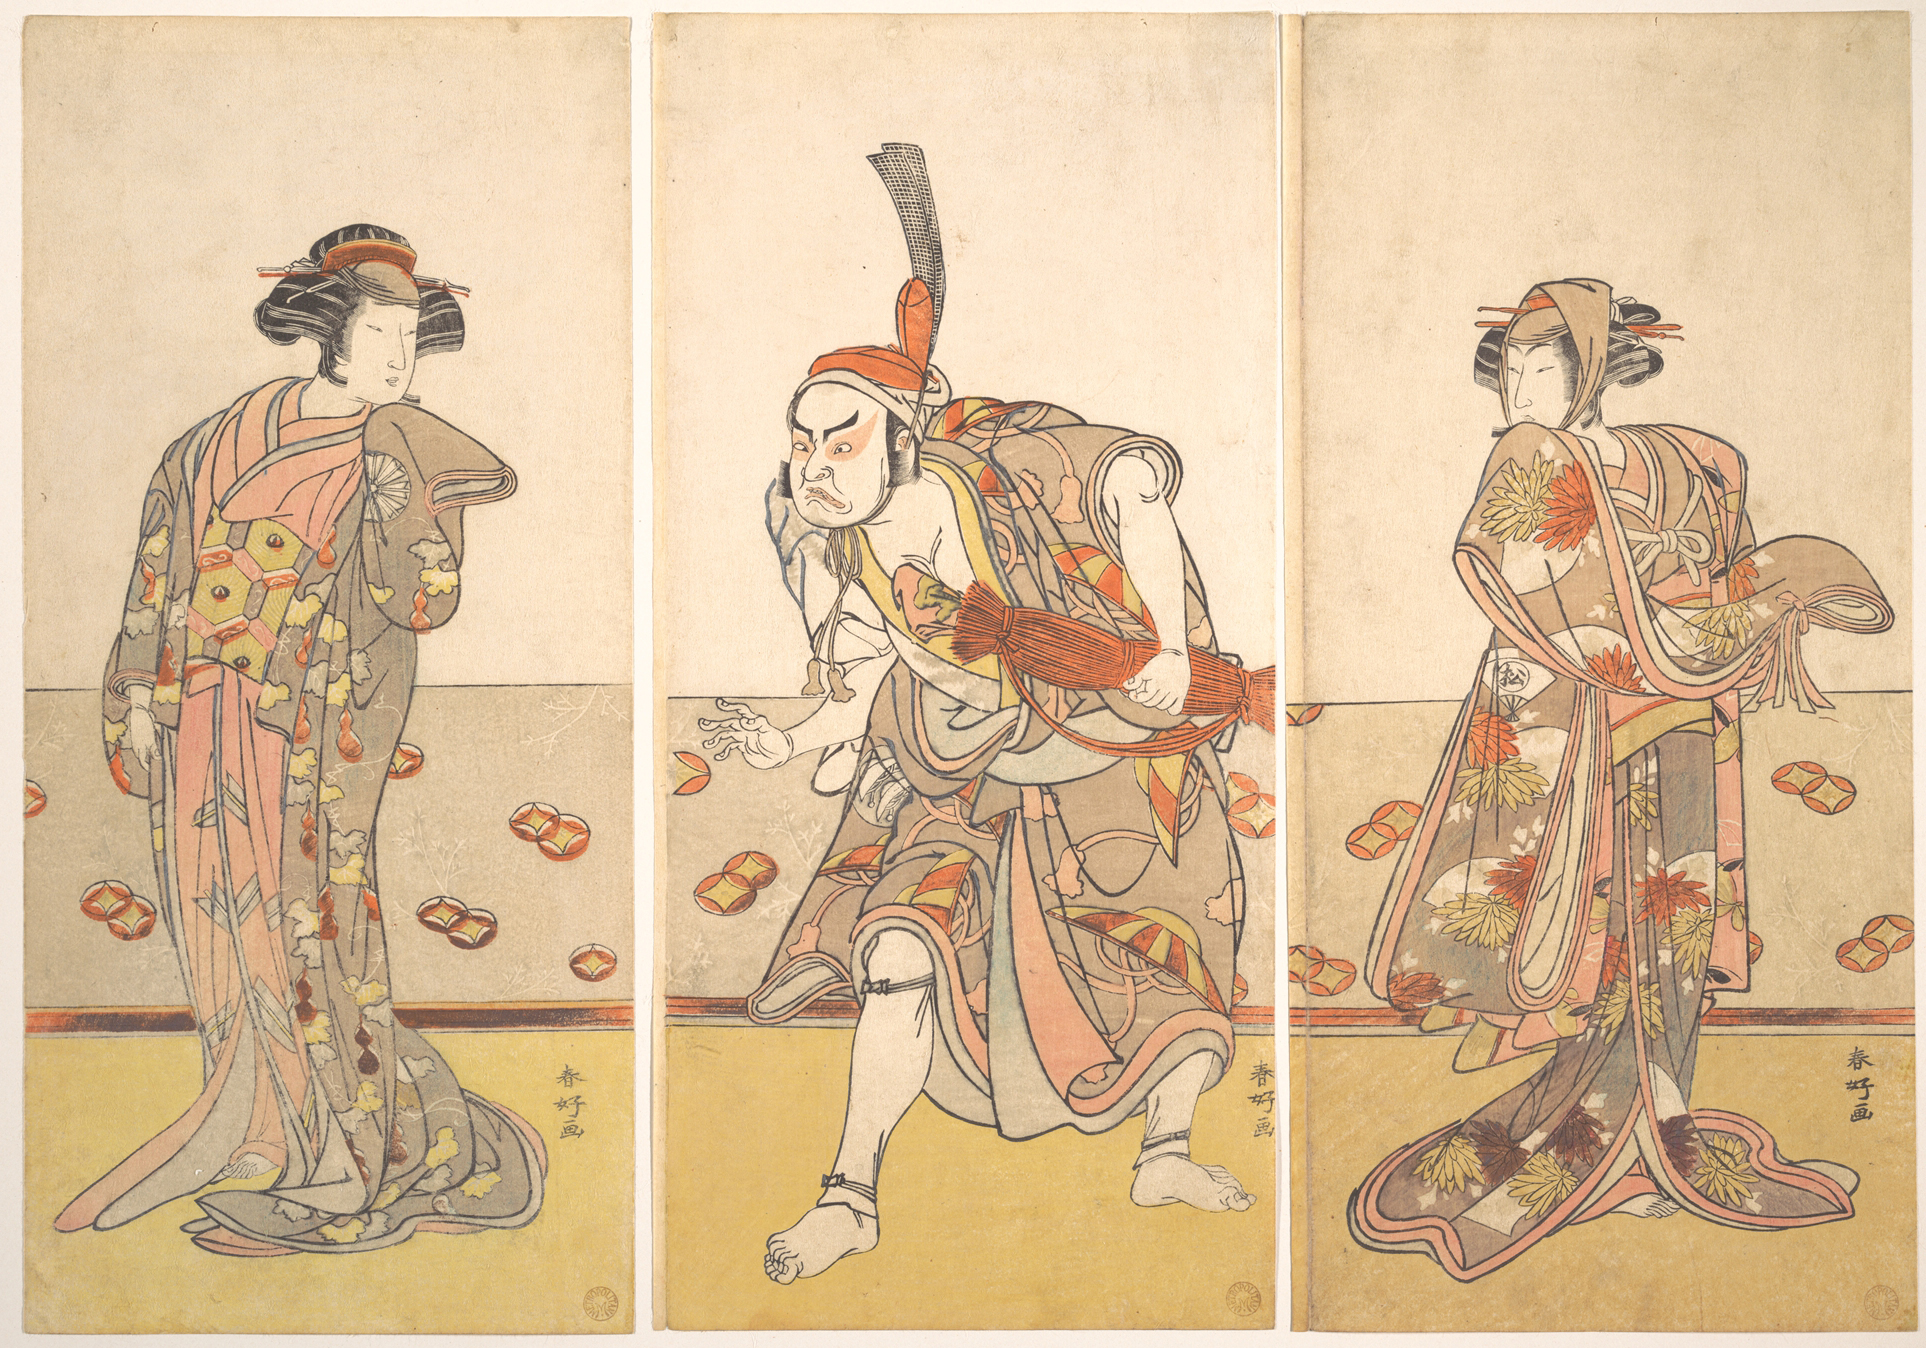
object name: print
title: The Actor Nakamura Tomijuro as a Stately Woman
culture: japanese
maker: katsukawa shunkō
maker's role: artist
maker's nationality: japanese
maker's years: 1743-1812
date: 1785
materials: ink, paper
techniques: woodblock print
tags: men,women,actors